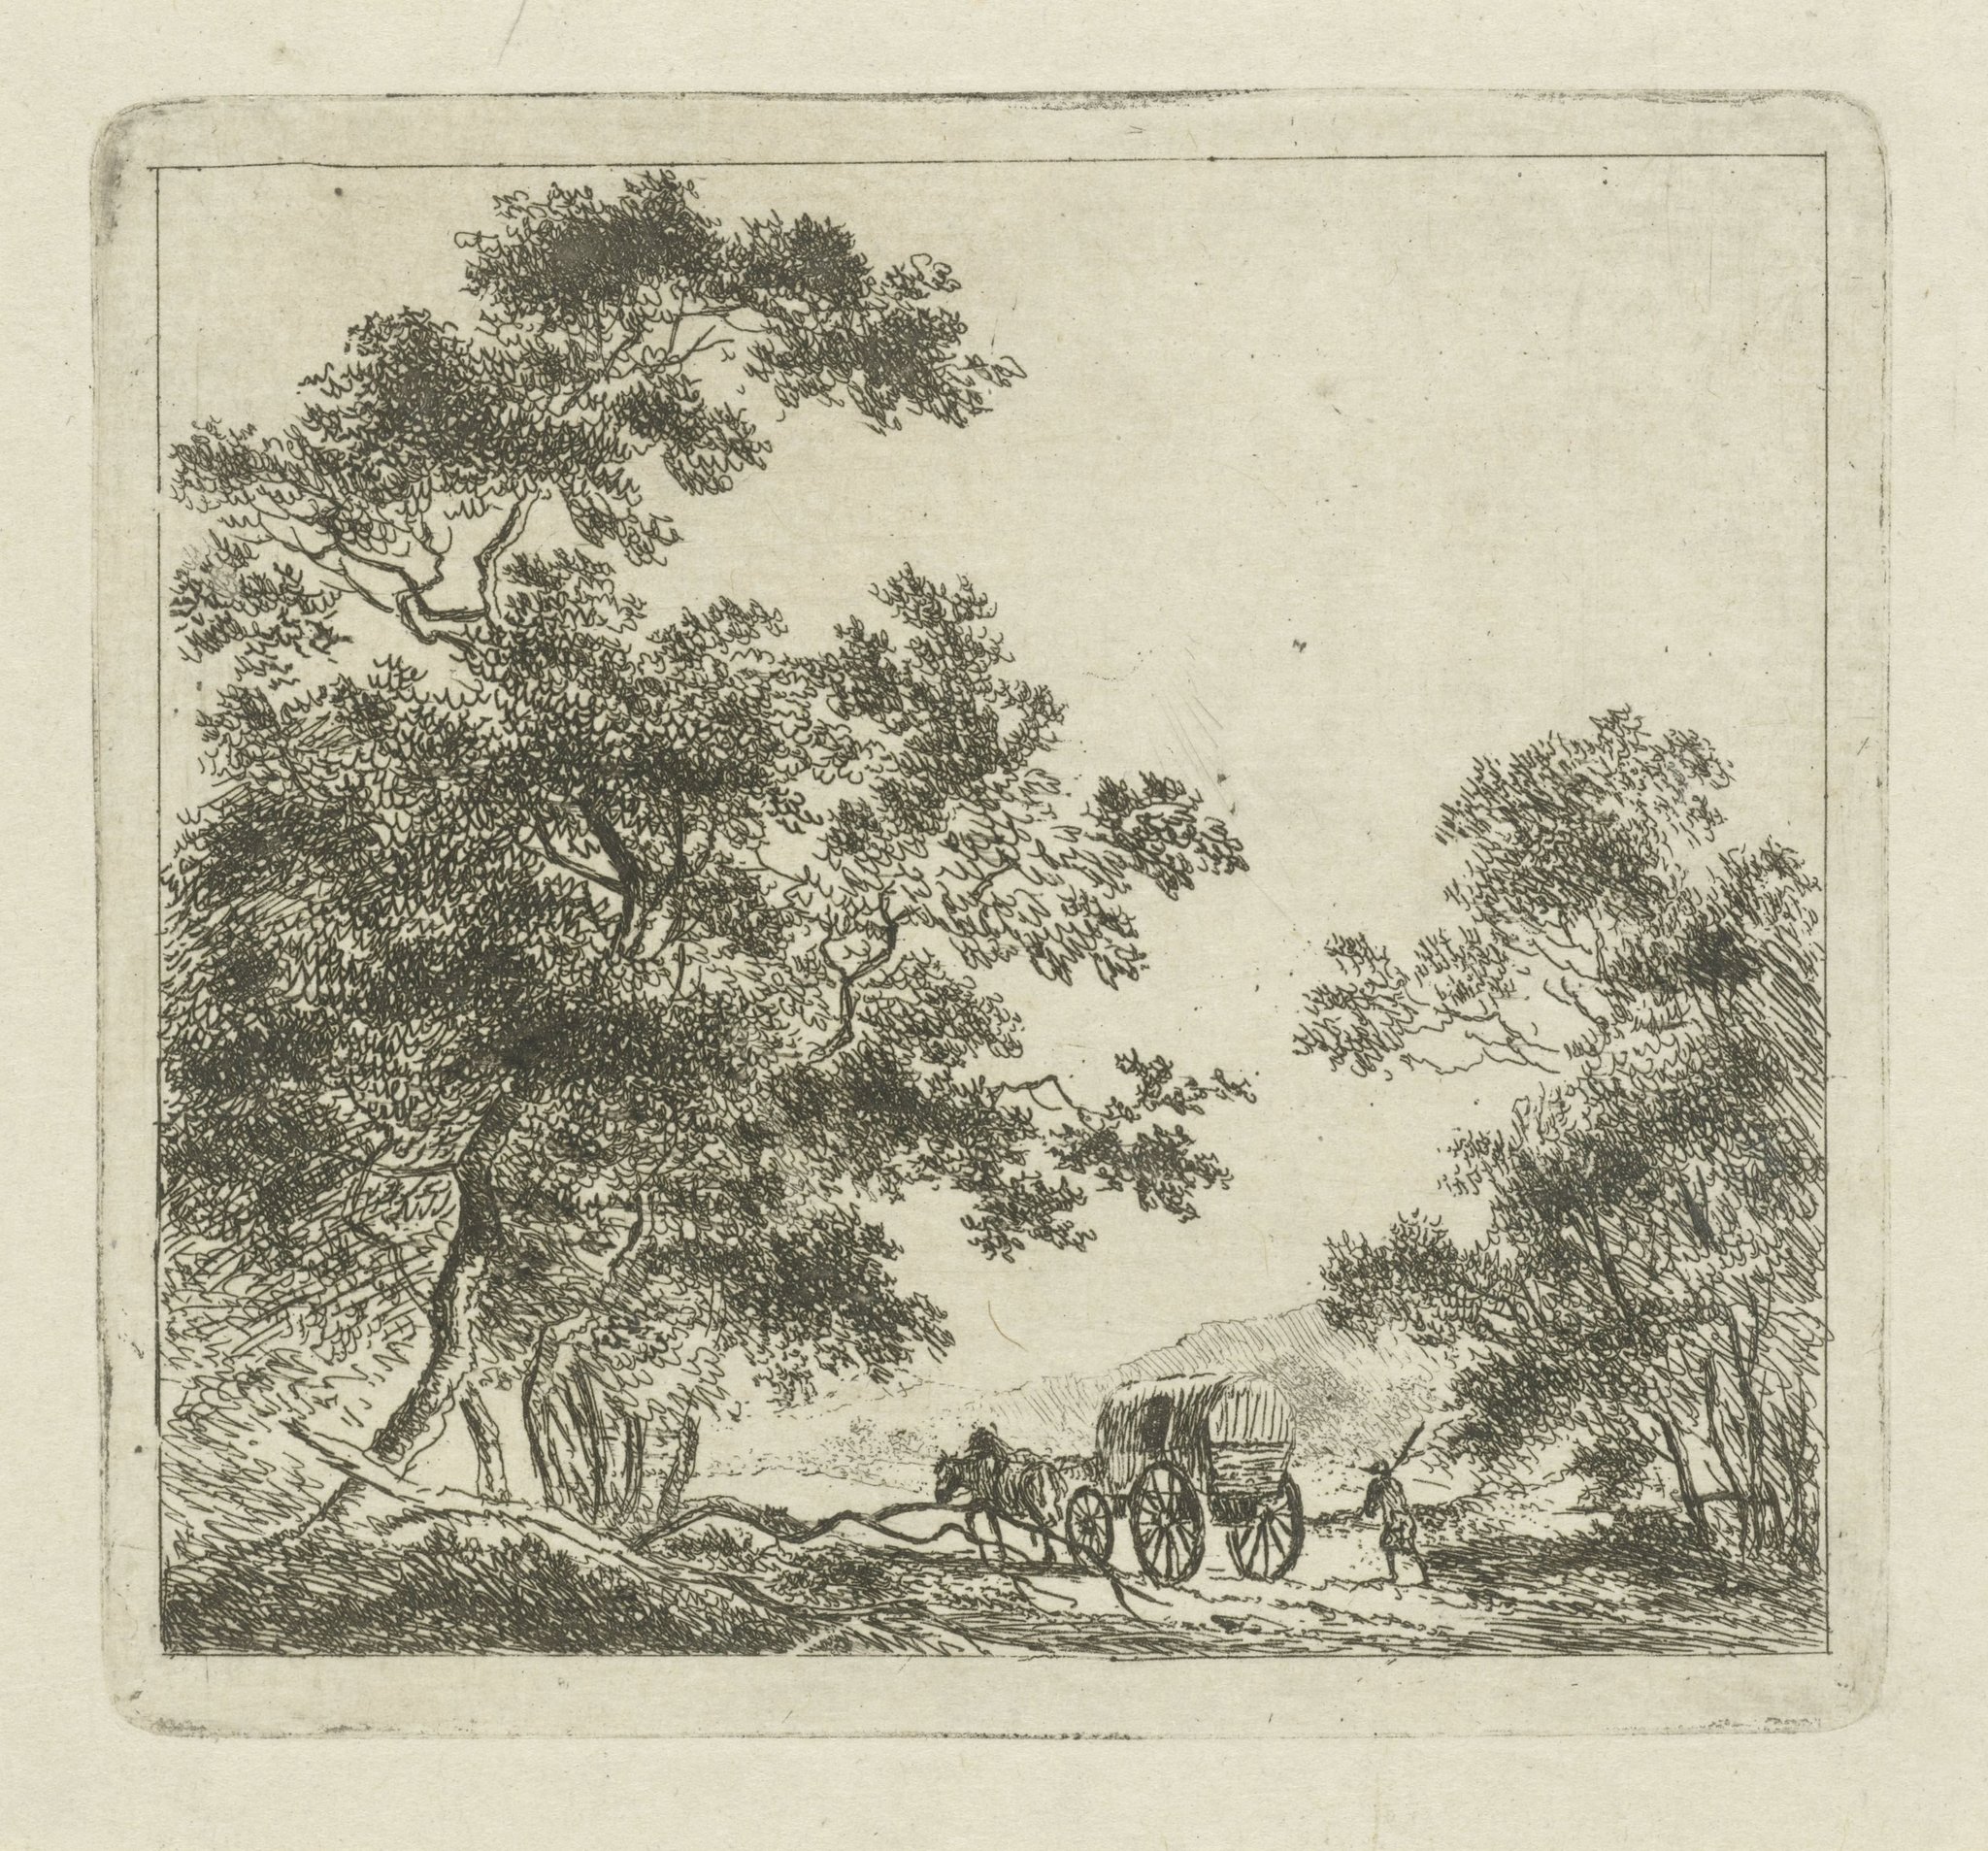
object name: print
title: Landschap met postwagen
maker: johannes janson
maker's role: draughtsman, painter, print maker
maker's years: 1729-1784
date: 1761-1784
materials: paper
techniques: etching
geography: leiden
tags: postal service, landscapes (+ landscape with figures, staffage)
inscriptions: collector's mark: Lugt 240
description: Bosweg met postwagen en een lopende figuur, op de rug gezien. Vóór de lucht.